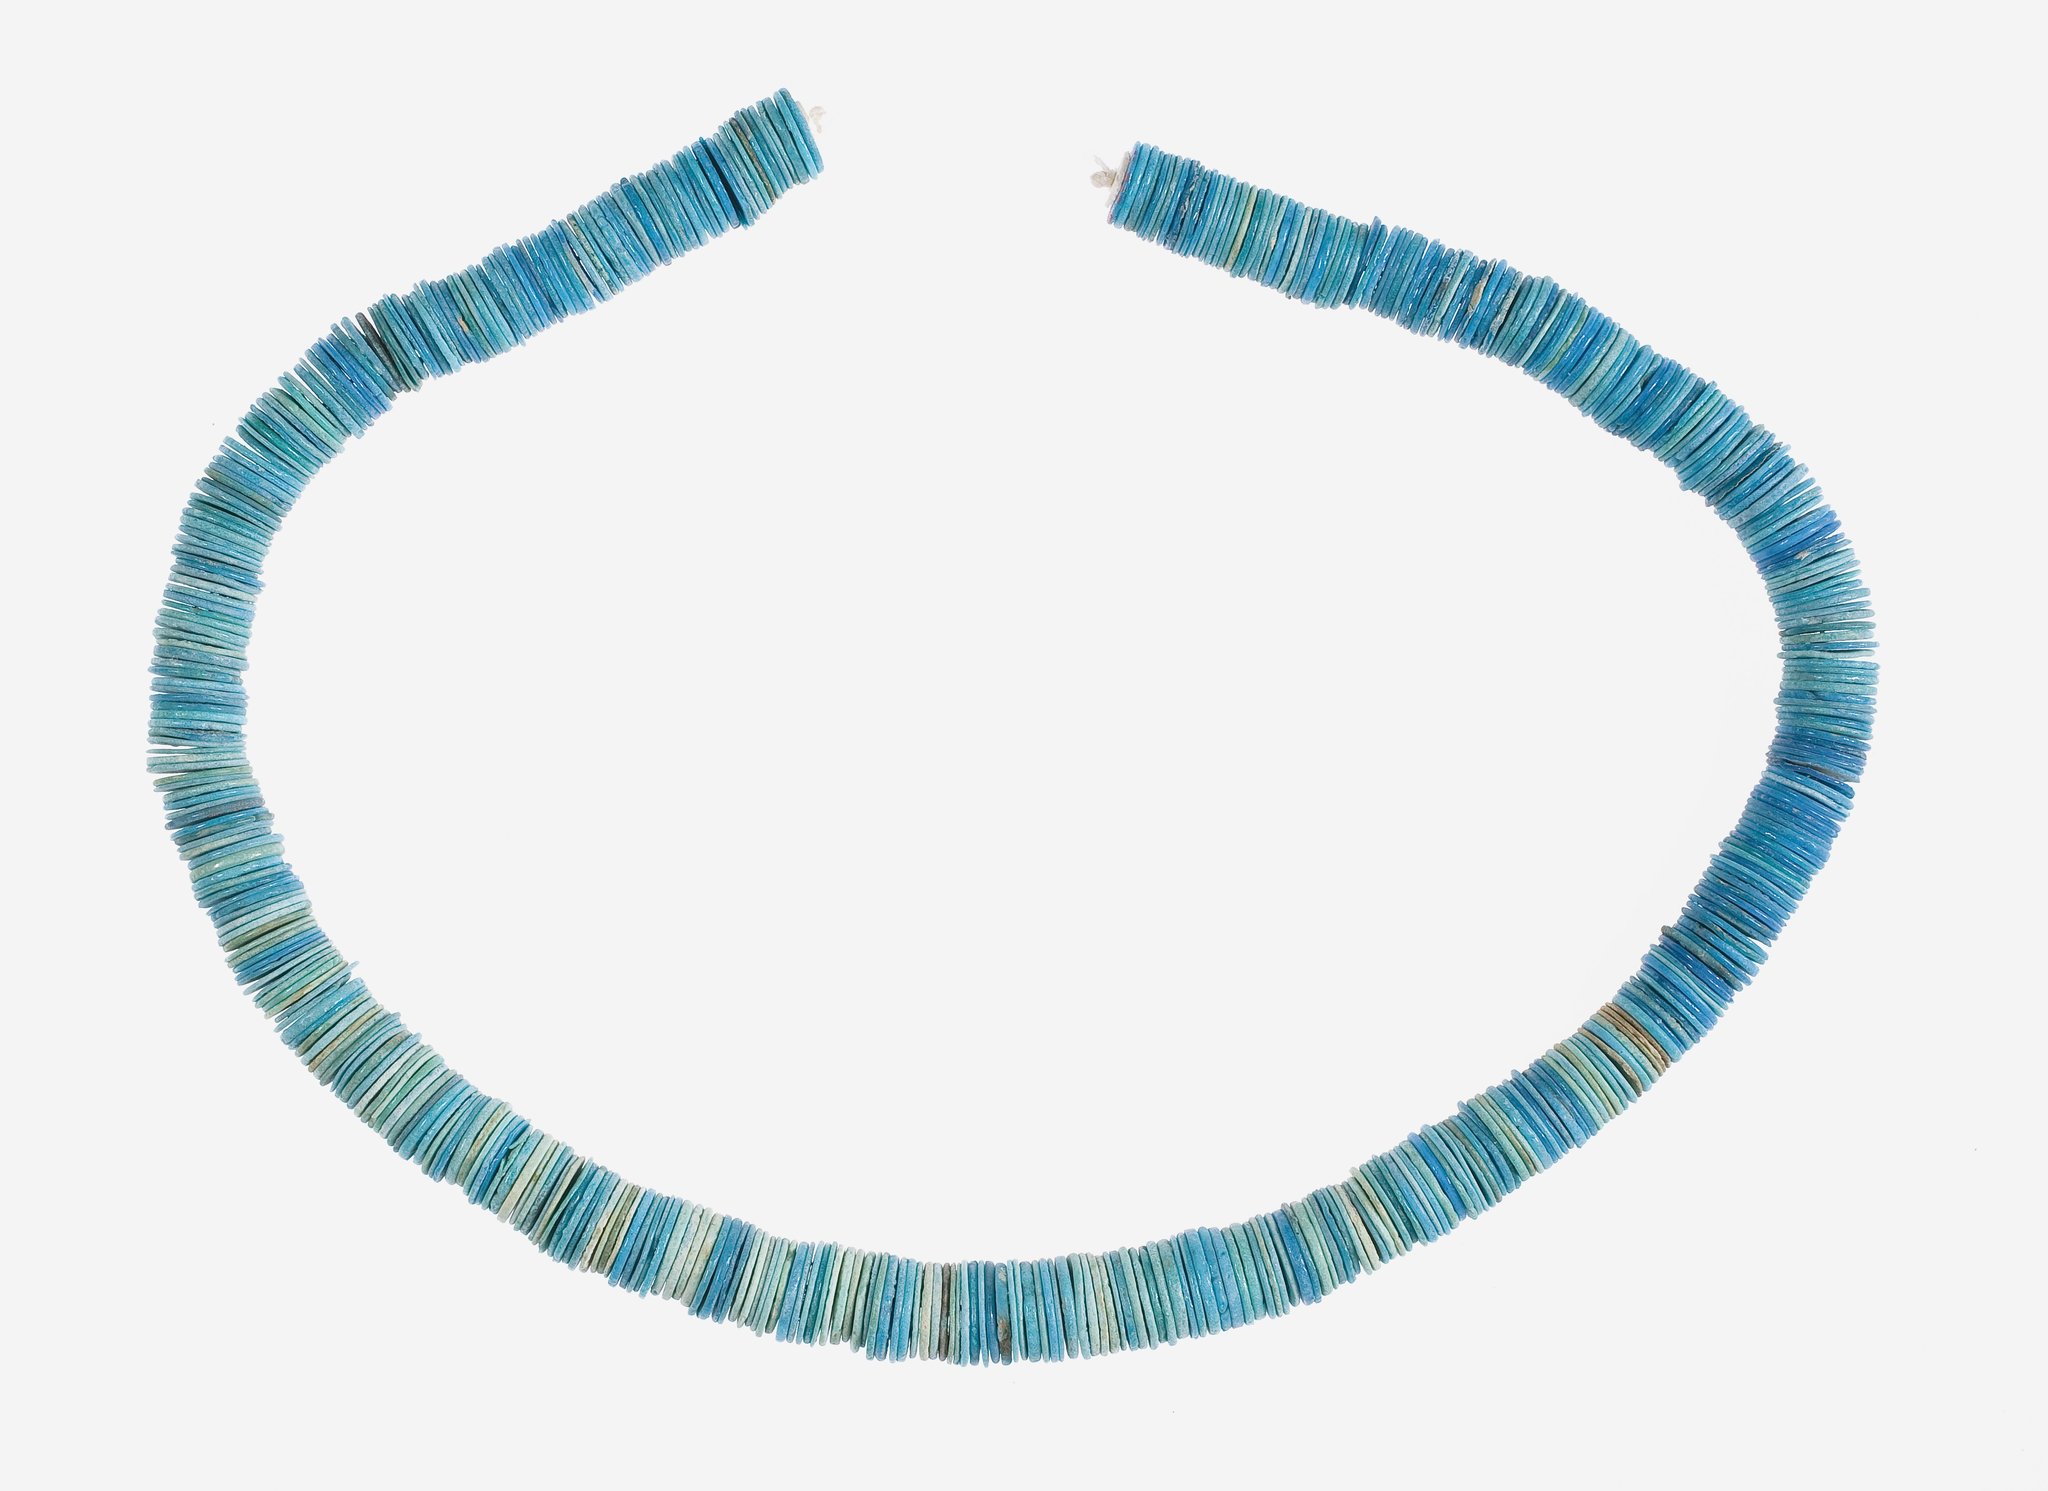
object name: bead, disk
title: String of Large Flat Disk Beads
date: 1390-1352 BCE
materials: faience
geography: egypt